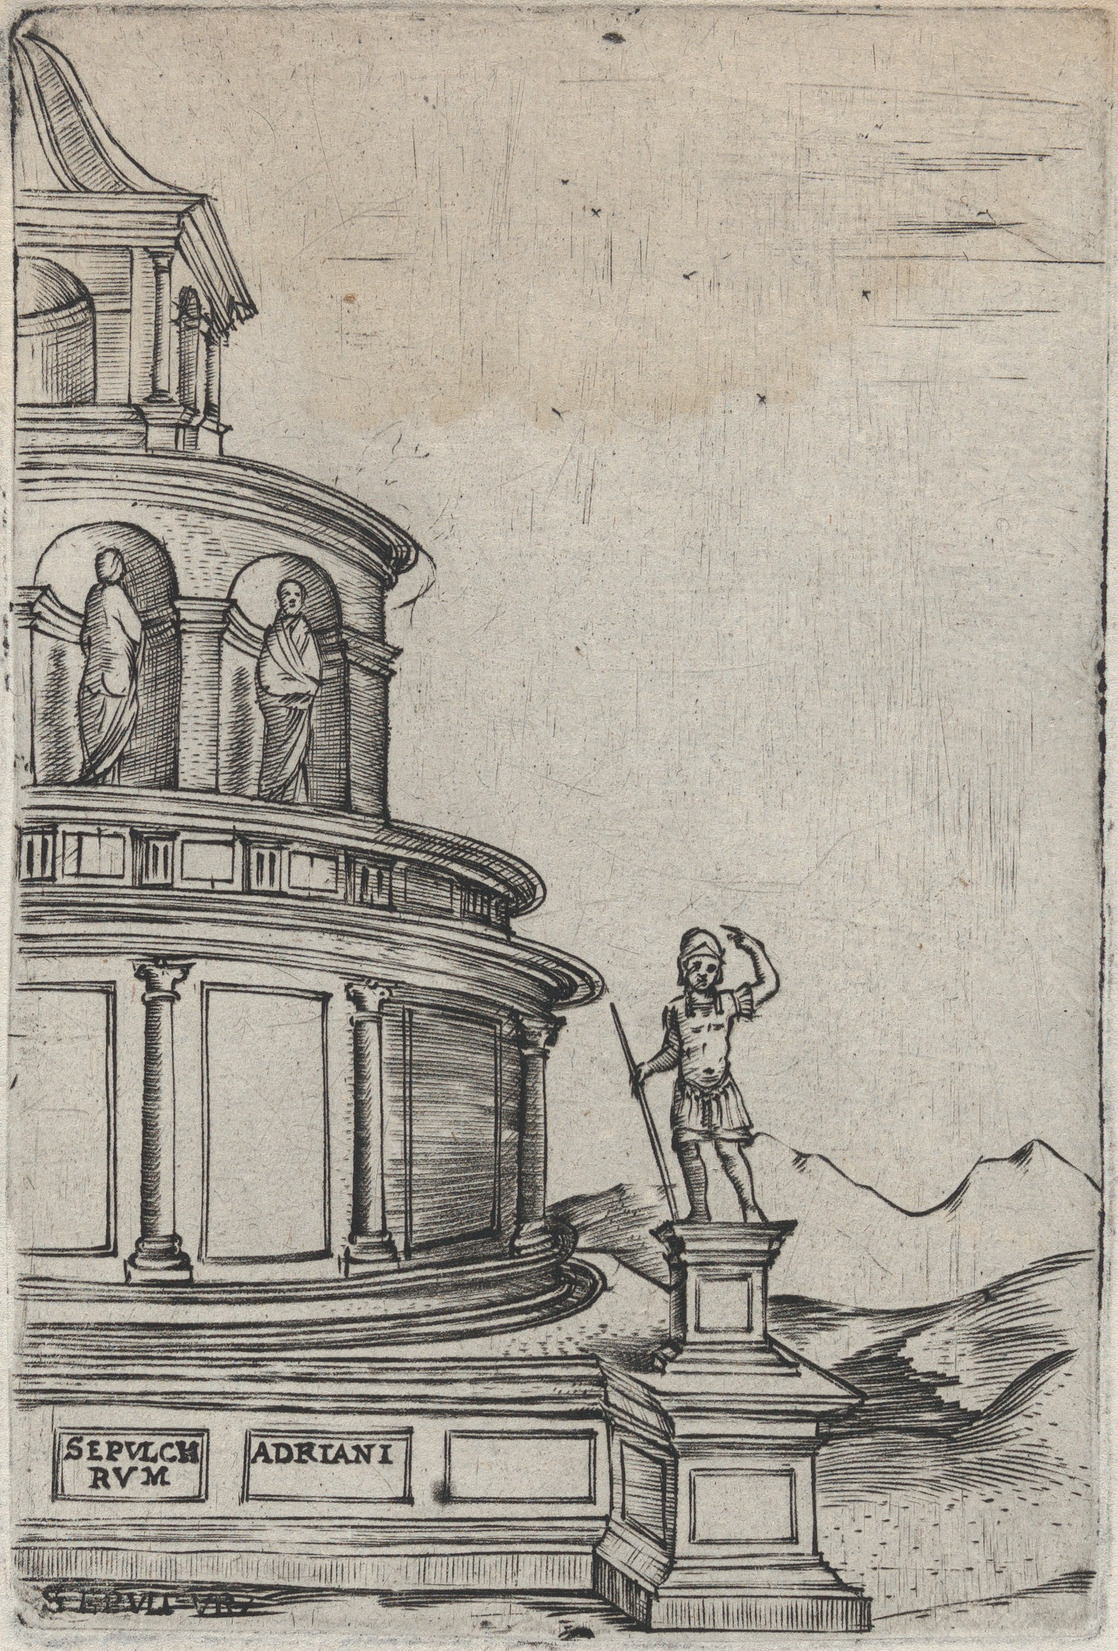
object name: print ornament architecture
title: Sepulchrum (sic) Adriani, from a Series of 24 Depicting (Reconstructed) Buildings from Roman Antiquity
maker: anonymous, italian, 16th century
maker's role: artist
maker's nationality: italian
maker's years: 1500-1600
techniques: engraving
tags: architecture,buildings